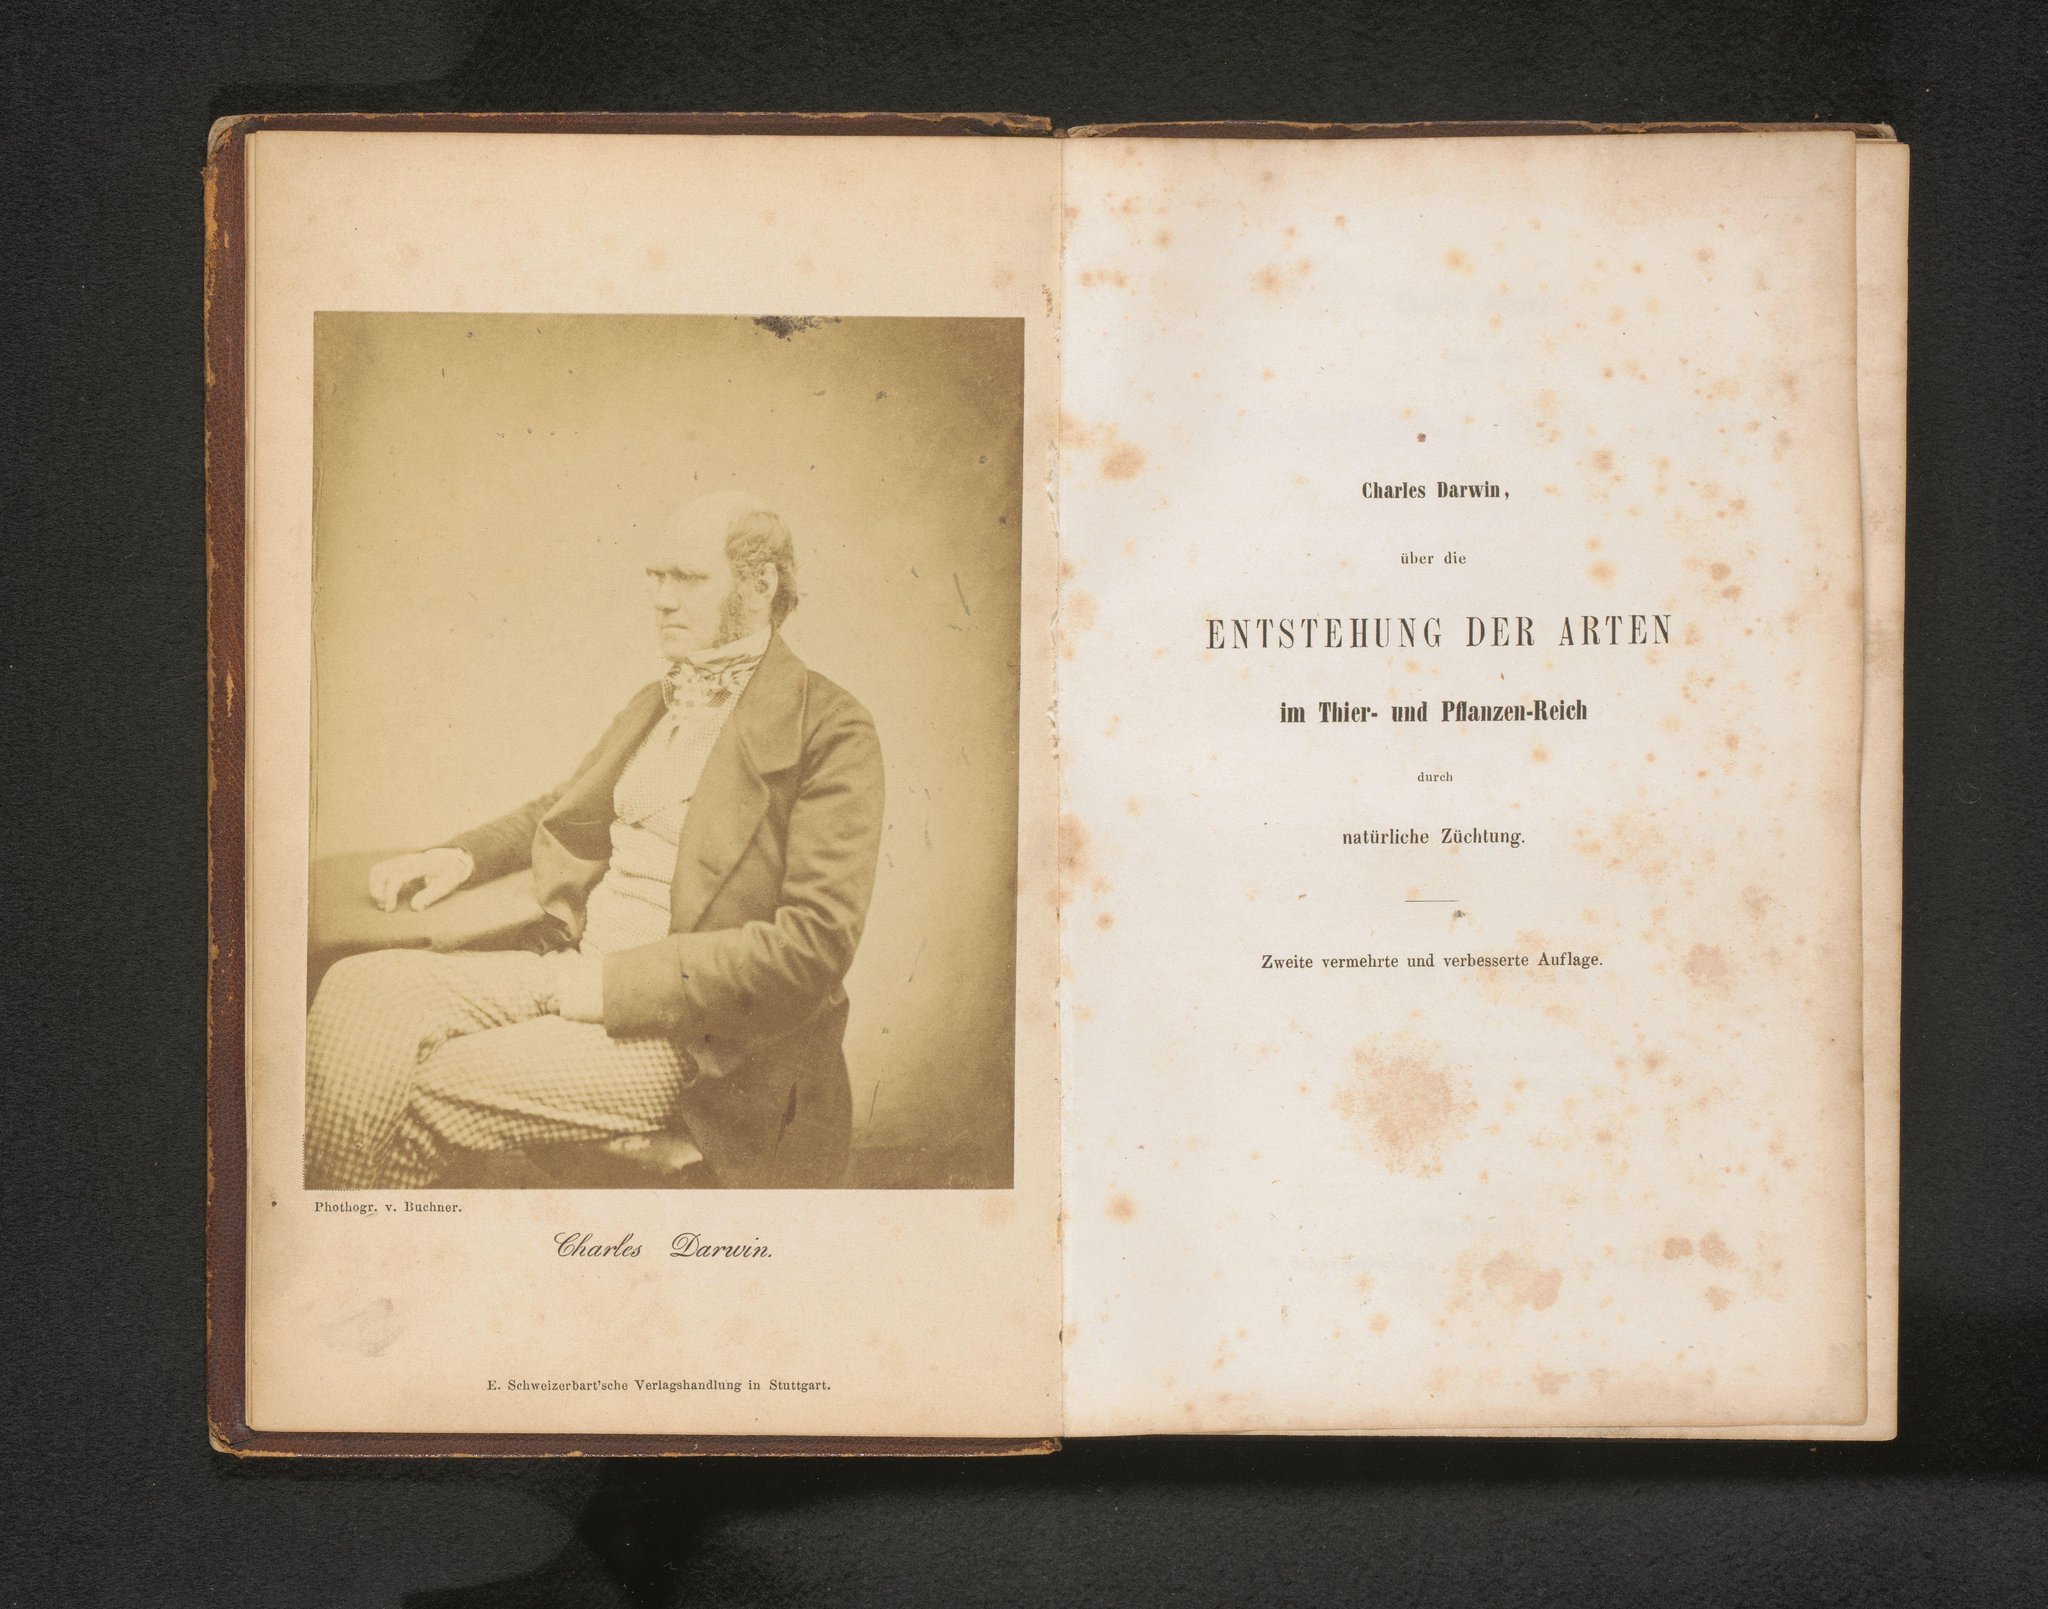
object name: page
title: Charles Darwin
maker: carl buchner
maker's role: fotograaf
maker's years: 1821-1918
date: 1858-1863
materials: photographic support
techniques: albumen print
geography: germany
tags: charles darwin, portrait of a writer